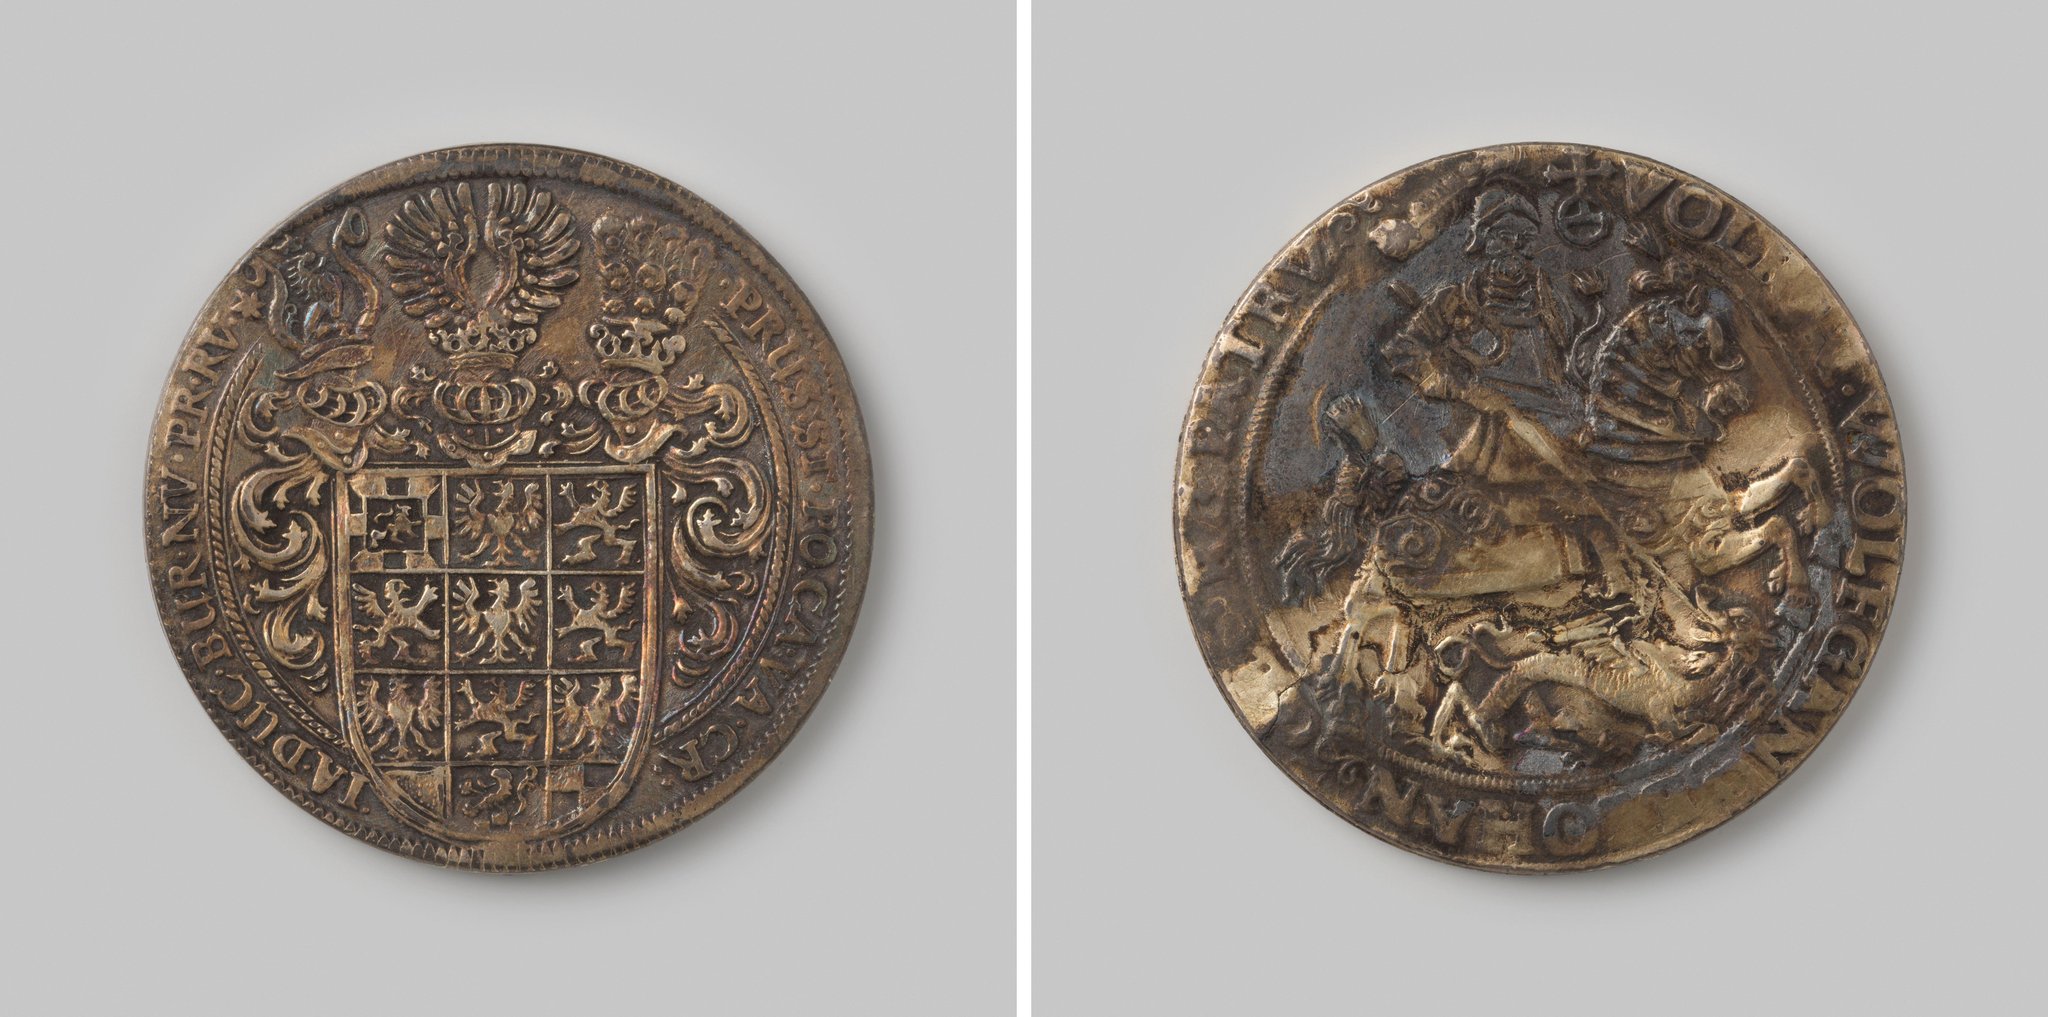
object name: coin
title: Taler (schroeftaler) uit het graafschap Mansfeld van Philip Ernst met de namen van Vollrad VI, Wolfgang III en Johann Georg IV van Mansfeld-Artern (1620-1628), tevens taler van Brandenburg-Ansbach van regent Sophie van Solms-Laubach, voor Friedrich, Albrecht en Christian (1625-1634)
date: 1625-1634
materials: silver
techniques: striking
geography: nuremberg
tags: regent, sophie van solms-laubach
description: Zilveren uitgeholde en, aan binnenzijde van de rand, van schroefdraad voorzien samenstel van twee munten, waarin mica-plaatjes met bijbelse voorstellingen. Voorzijde: samengesteld wapenschild, waarop drie helmtekens. Keerzijde: Taler van Friedrich, Albrecht en Christian van Brandenburg-Ansbach. Gladde rand.